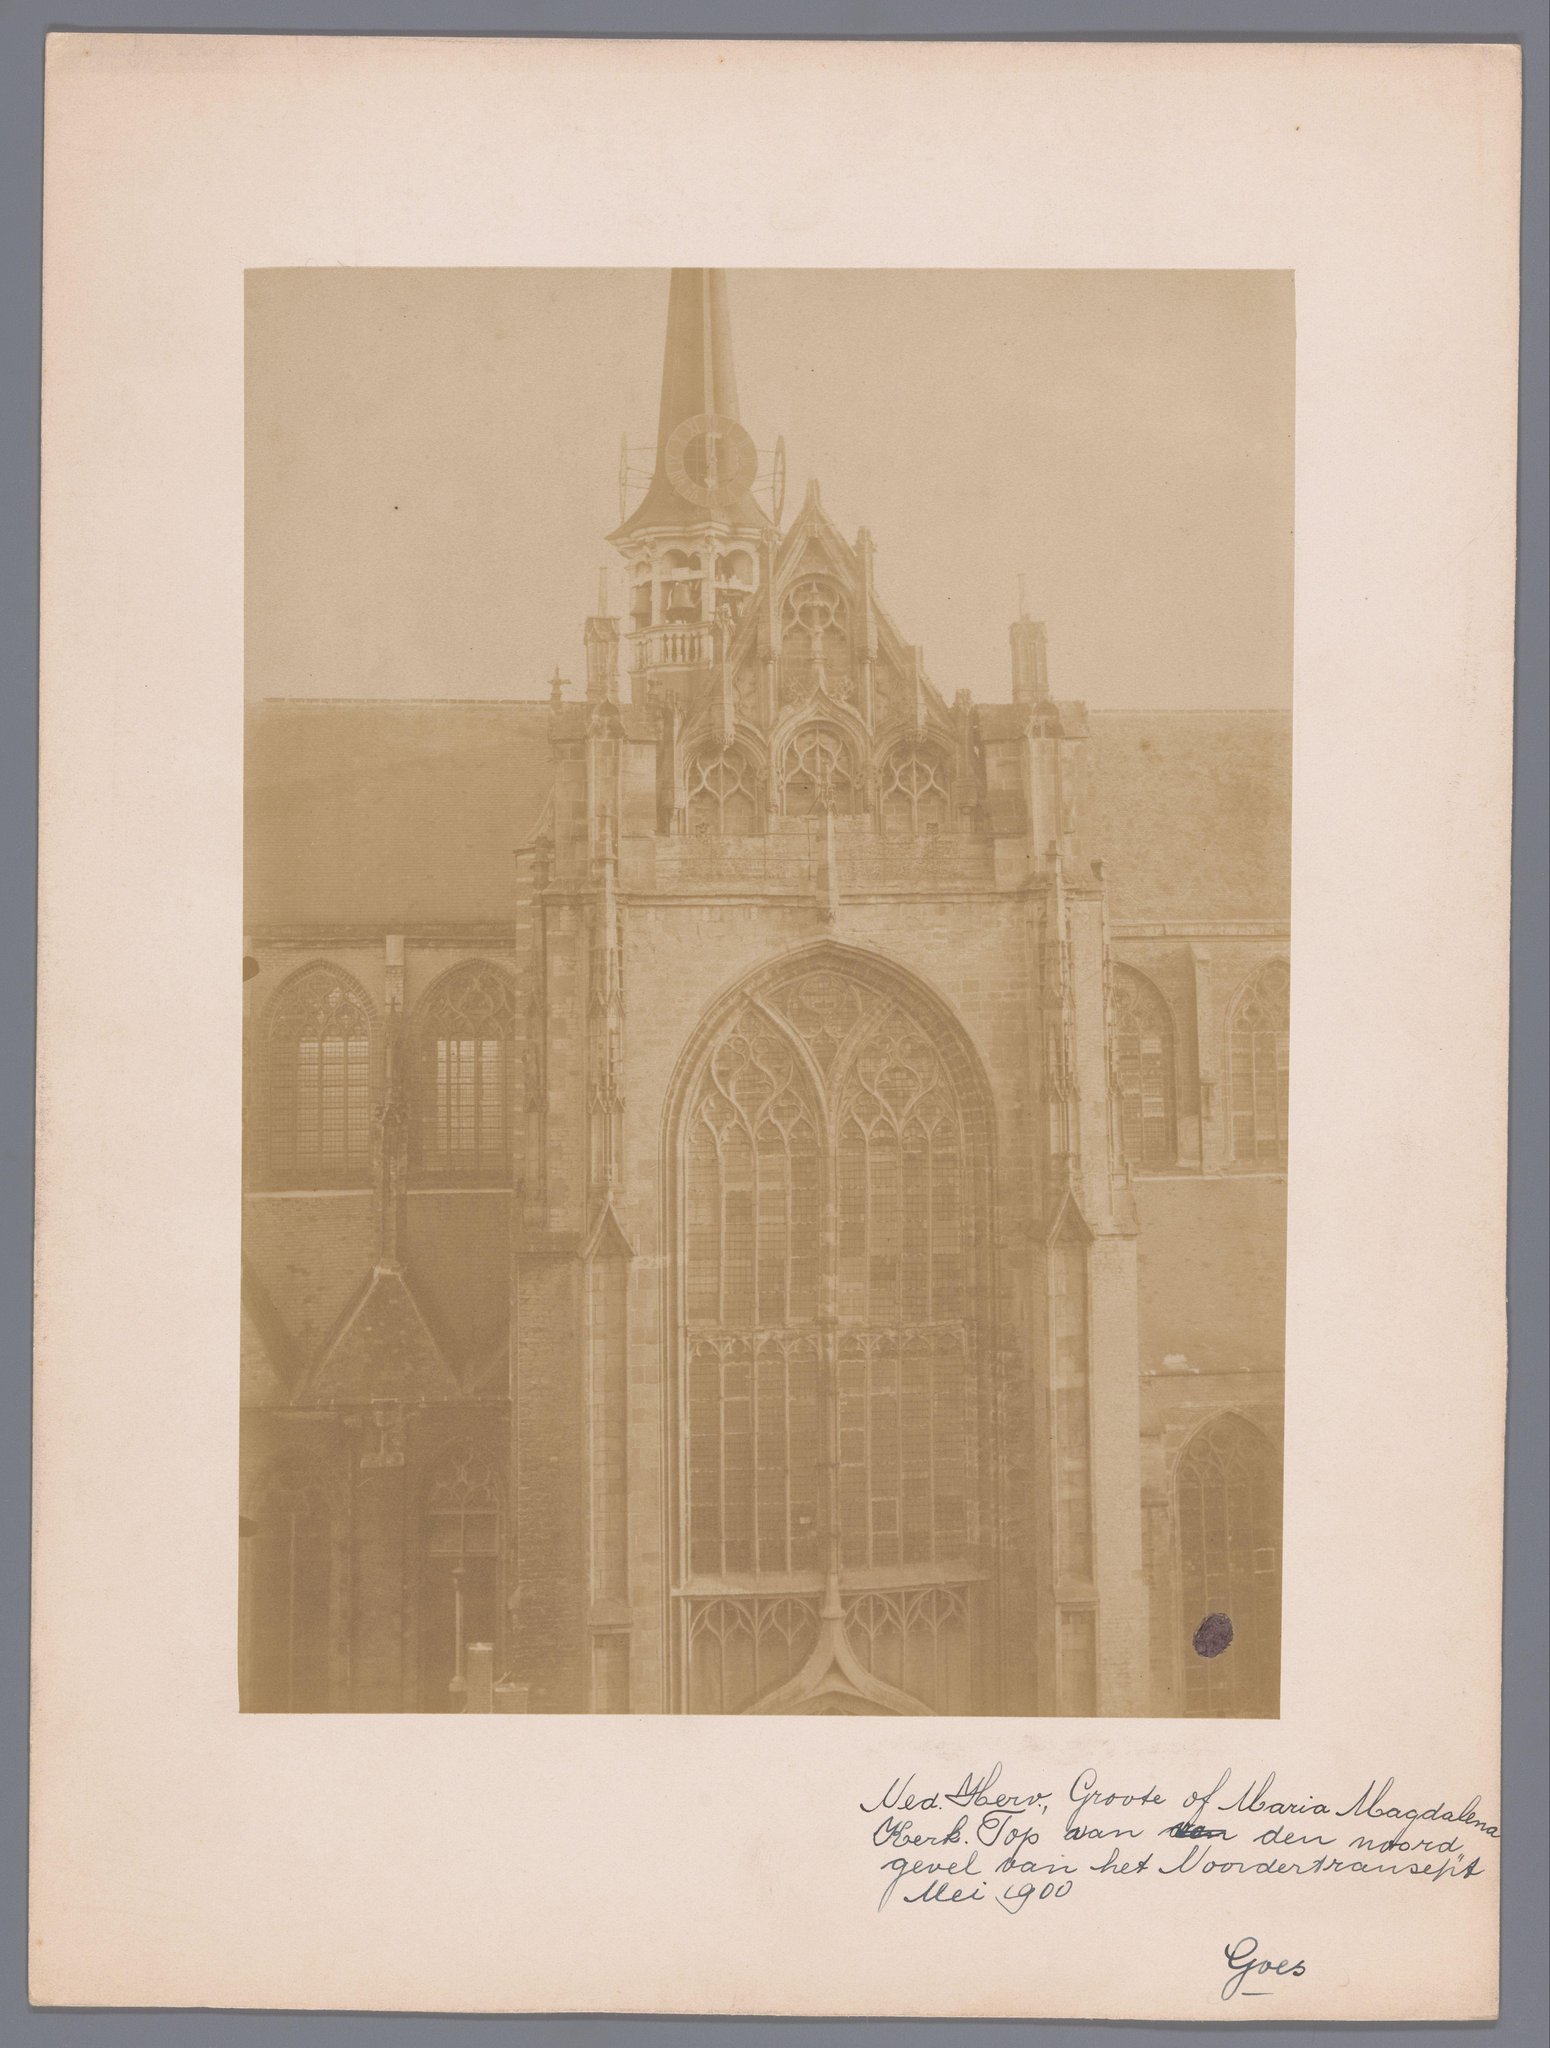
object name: photograph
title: Noordzijde van de Grote of Maria Magdalenakerk te Goes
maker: anoniem (monumentenzorg)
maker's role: fotograaf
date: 1900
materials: cardboard, photographic support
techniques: albumen print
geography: goes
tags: parts of church exterior and annexes: transept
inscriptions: annotation: ‘Ned. Herv., Groote of Maria Magdalena Kerk. Top van den noordgevel van het Noordertransept/ Mei 1900/ Goes’, annotation: ‘Groote of St. Magdalenakerk te Goes (Z.)/ Top van den noordgevel van het noordertransept/ Mei 1900’